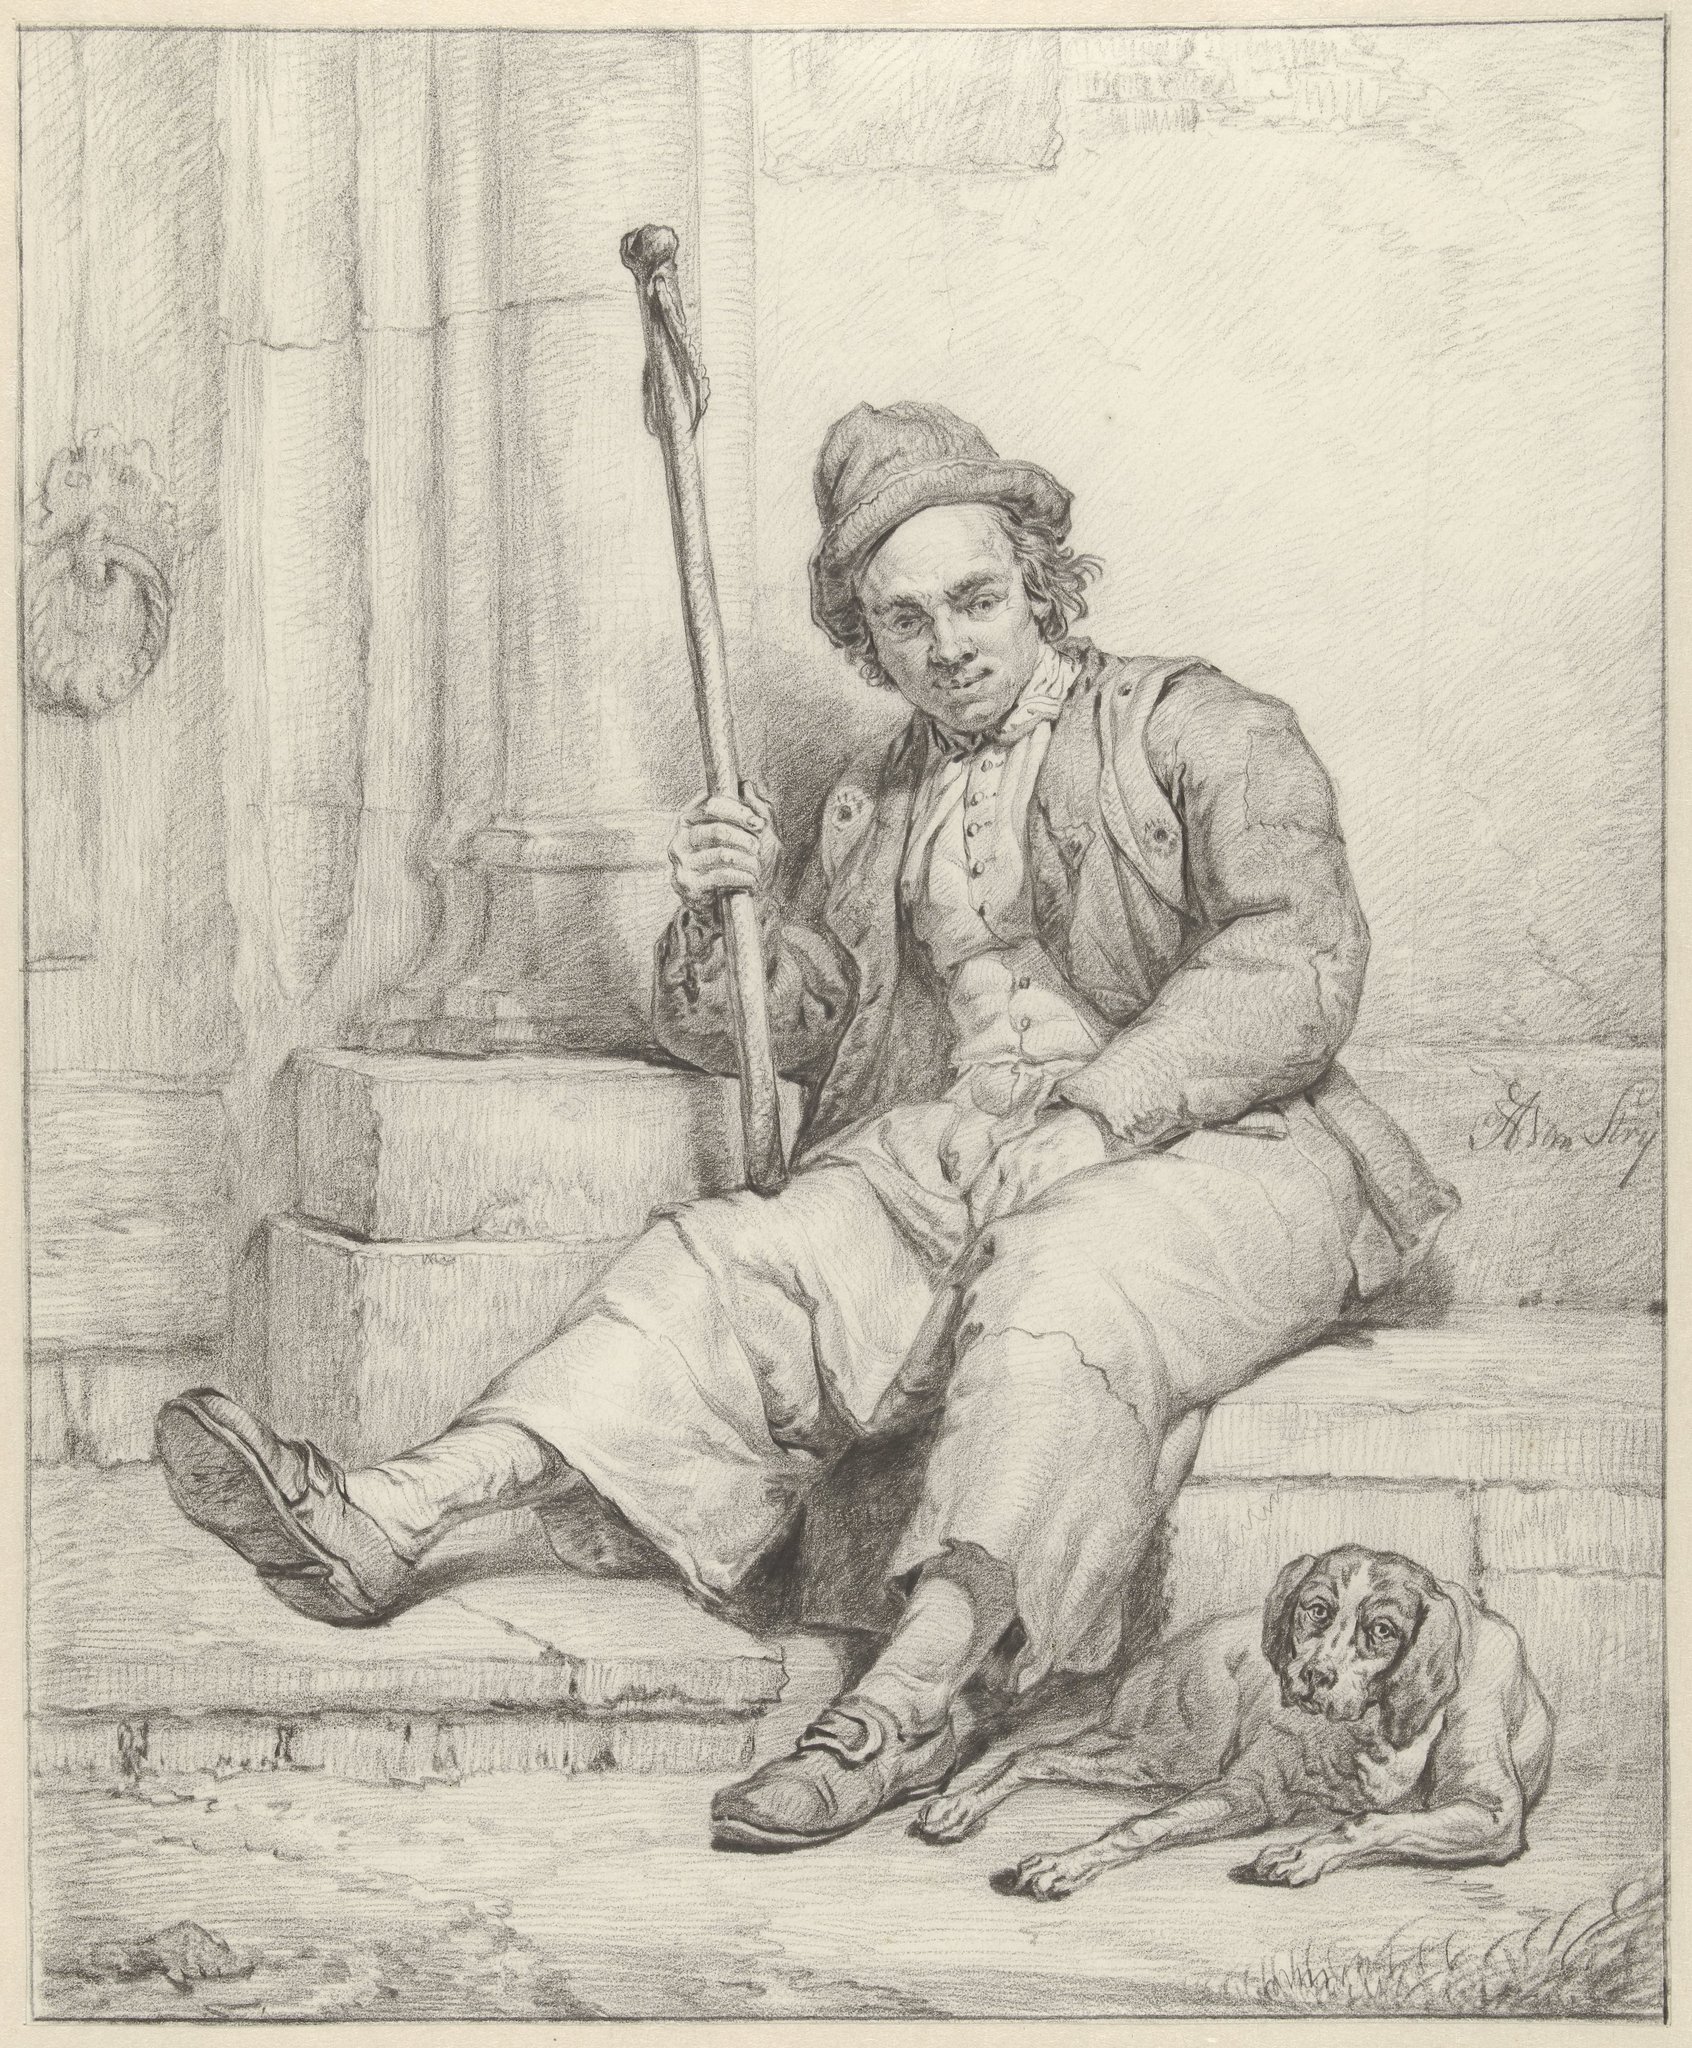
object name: drawing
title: Zittende man met hond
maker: abraham van strij (i)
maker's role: draughtsman, painter, print maker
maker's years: 1753-1826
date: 1763-1826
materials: paper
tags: dog